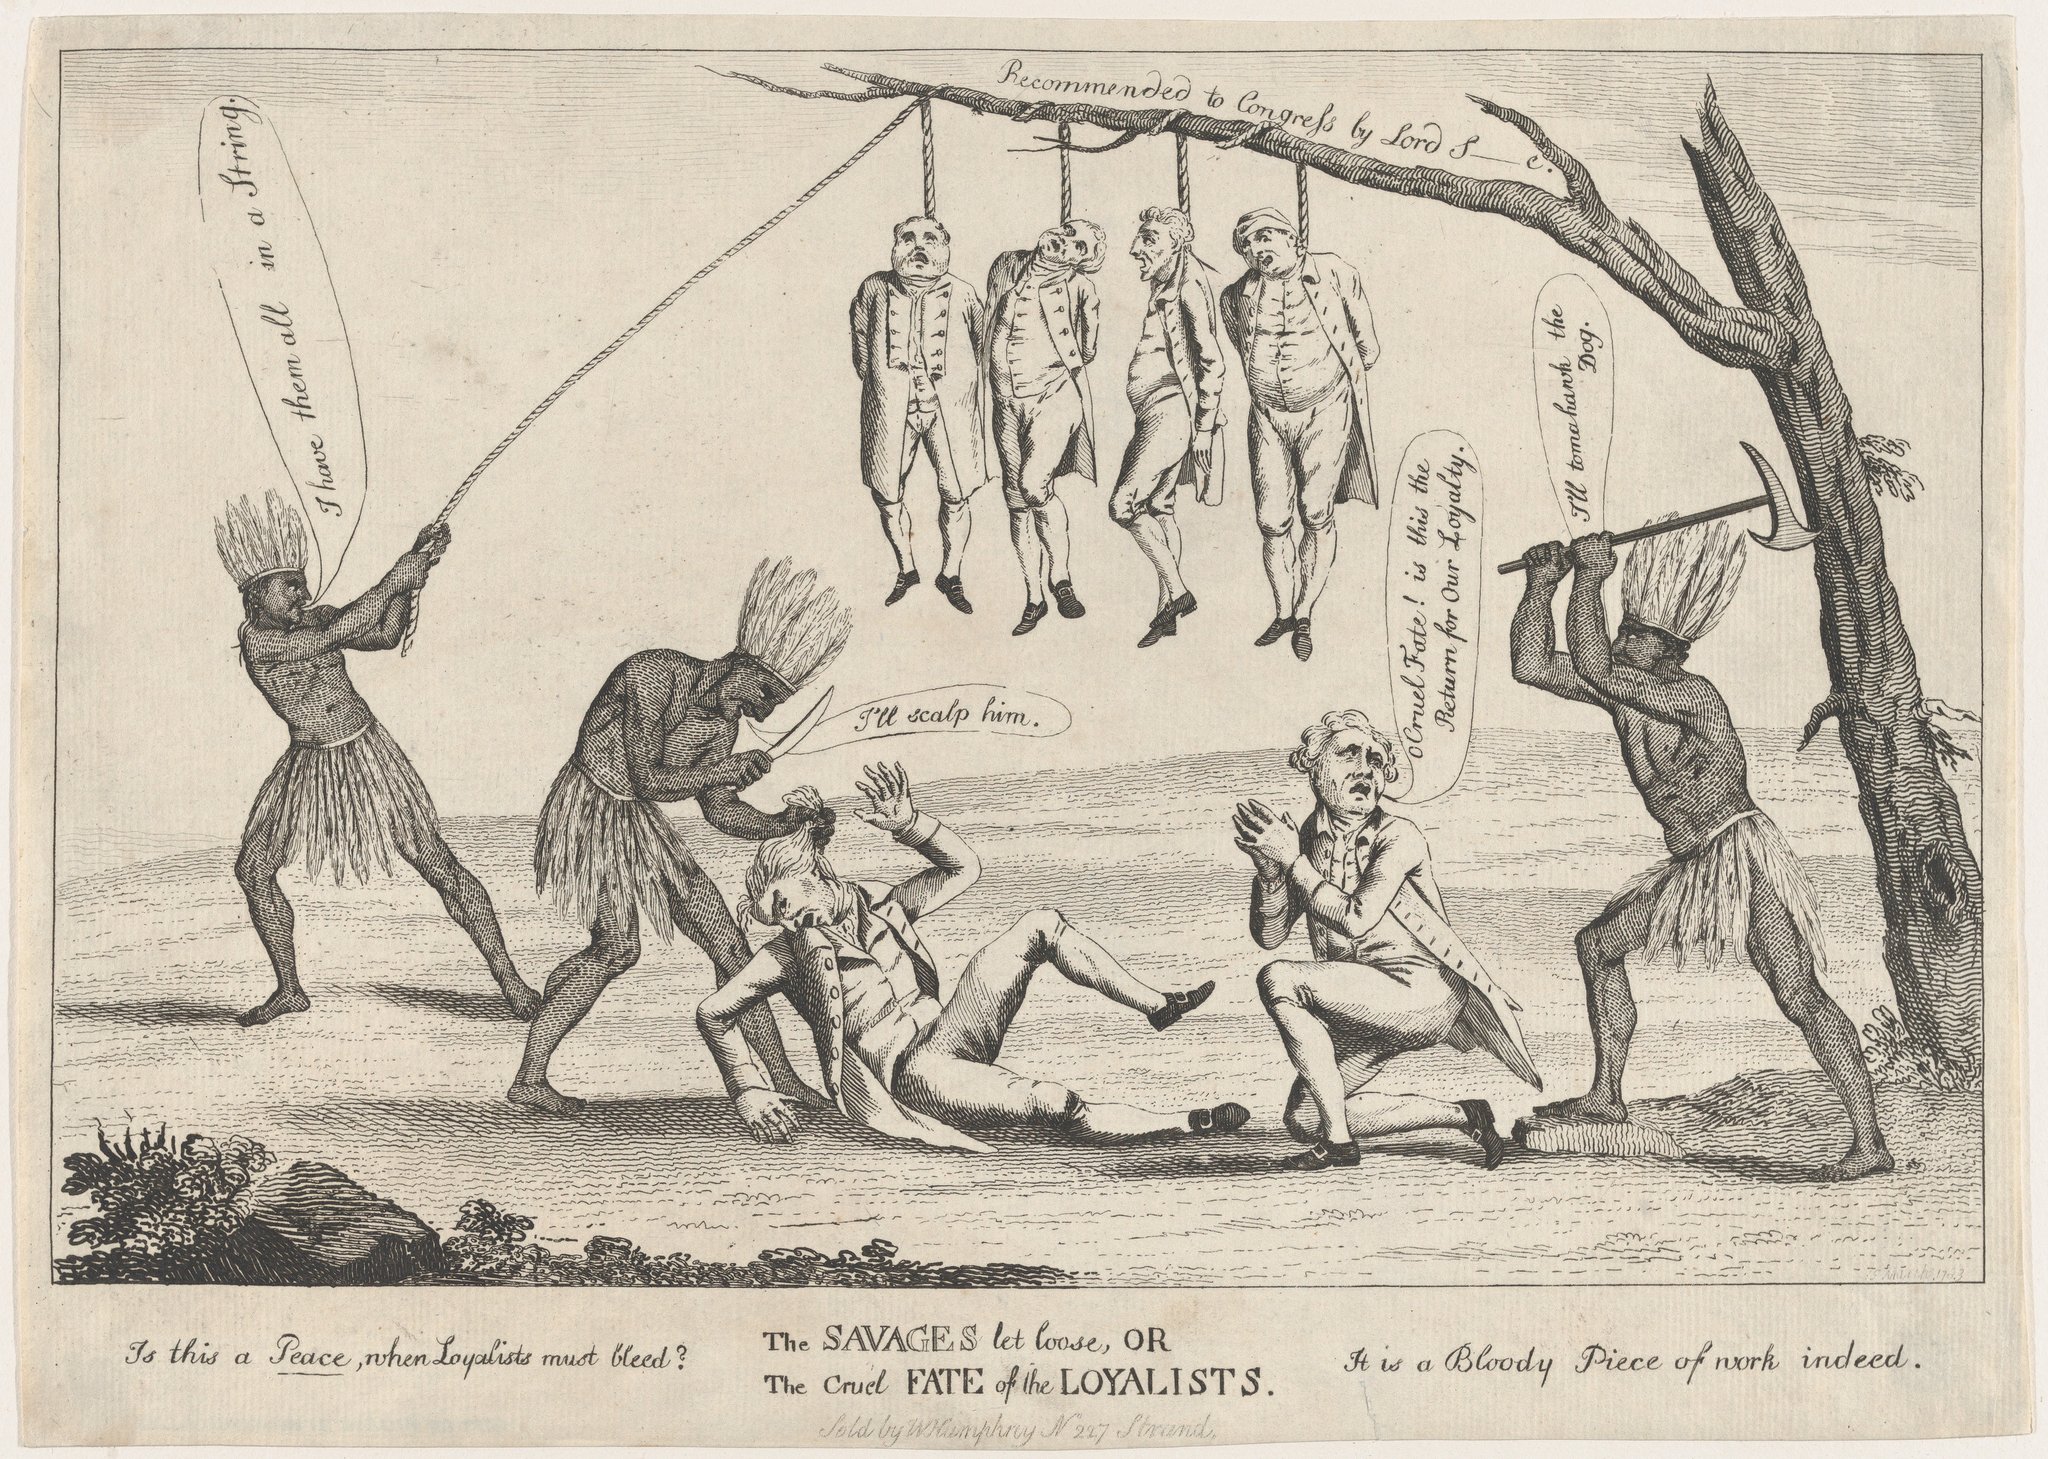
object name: print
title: The Savages Let Loose, or the Cruel Fate of the Loyalists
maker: william humphrey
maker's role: publisher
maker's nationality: british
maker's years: 1740-1814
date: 1783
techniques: engraving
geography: london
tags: satire,american revolution,men,politics